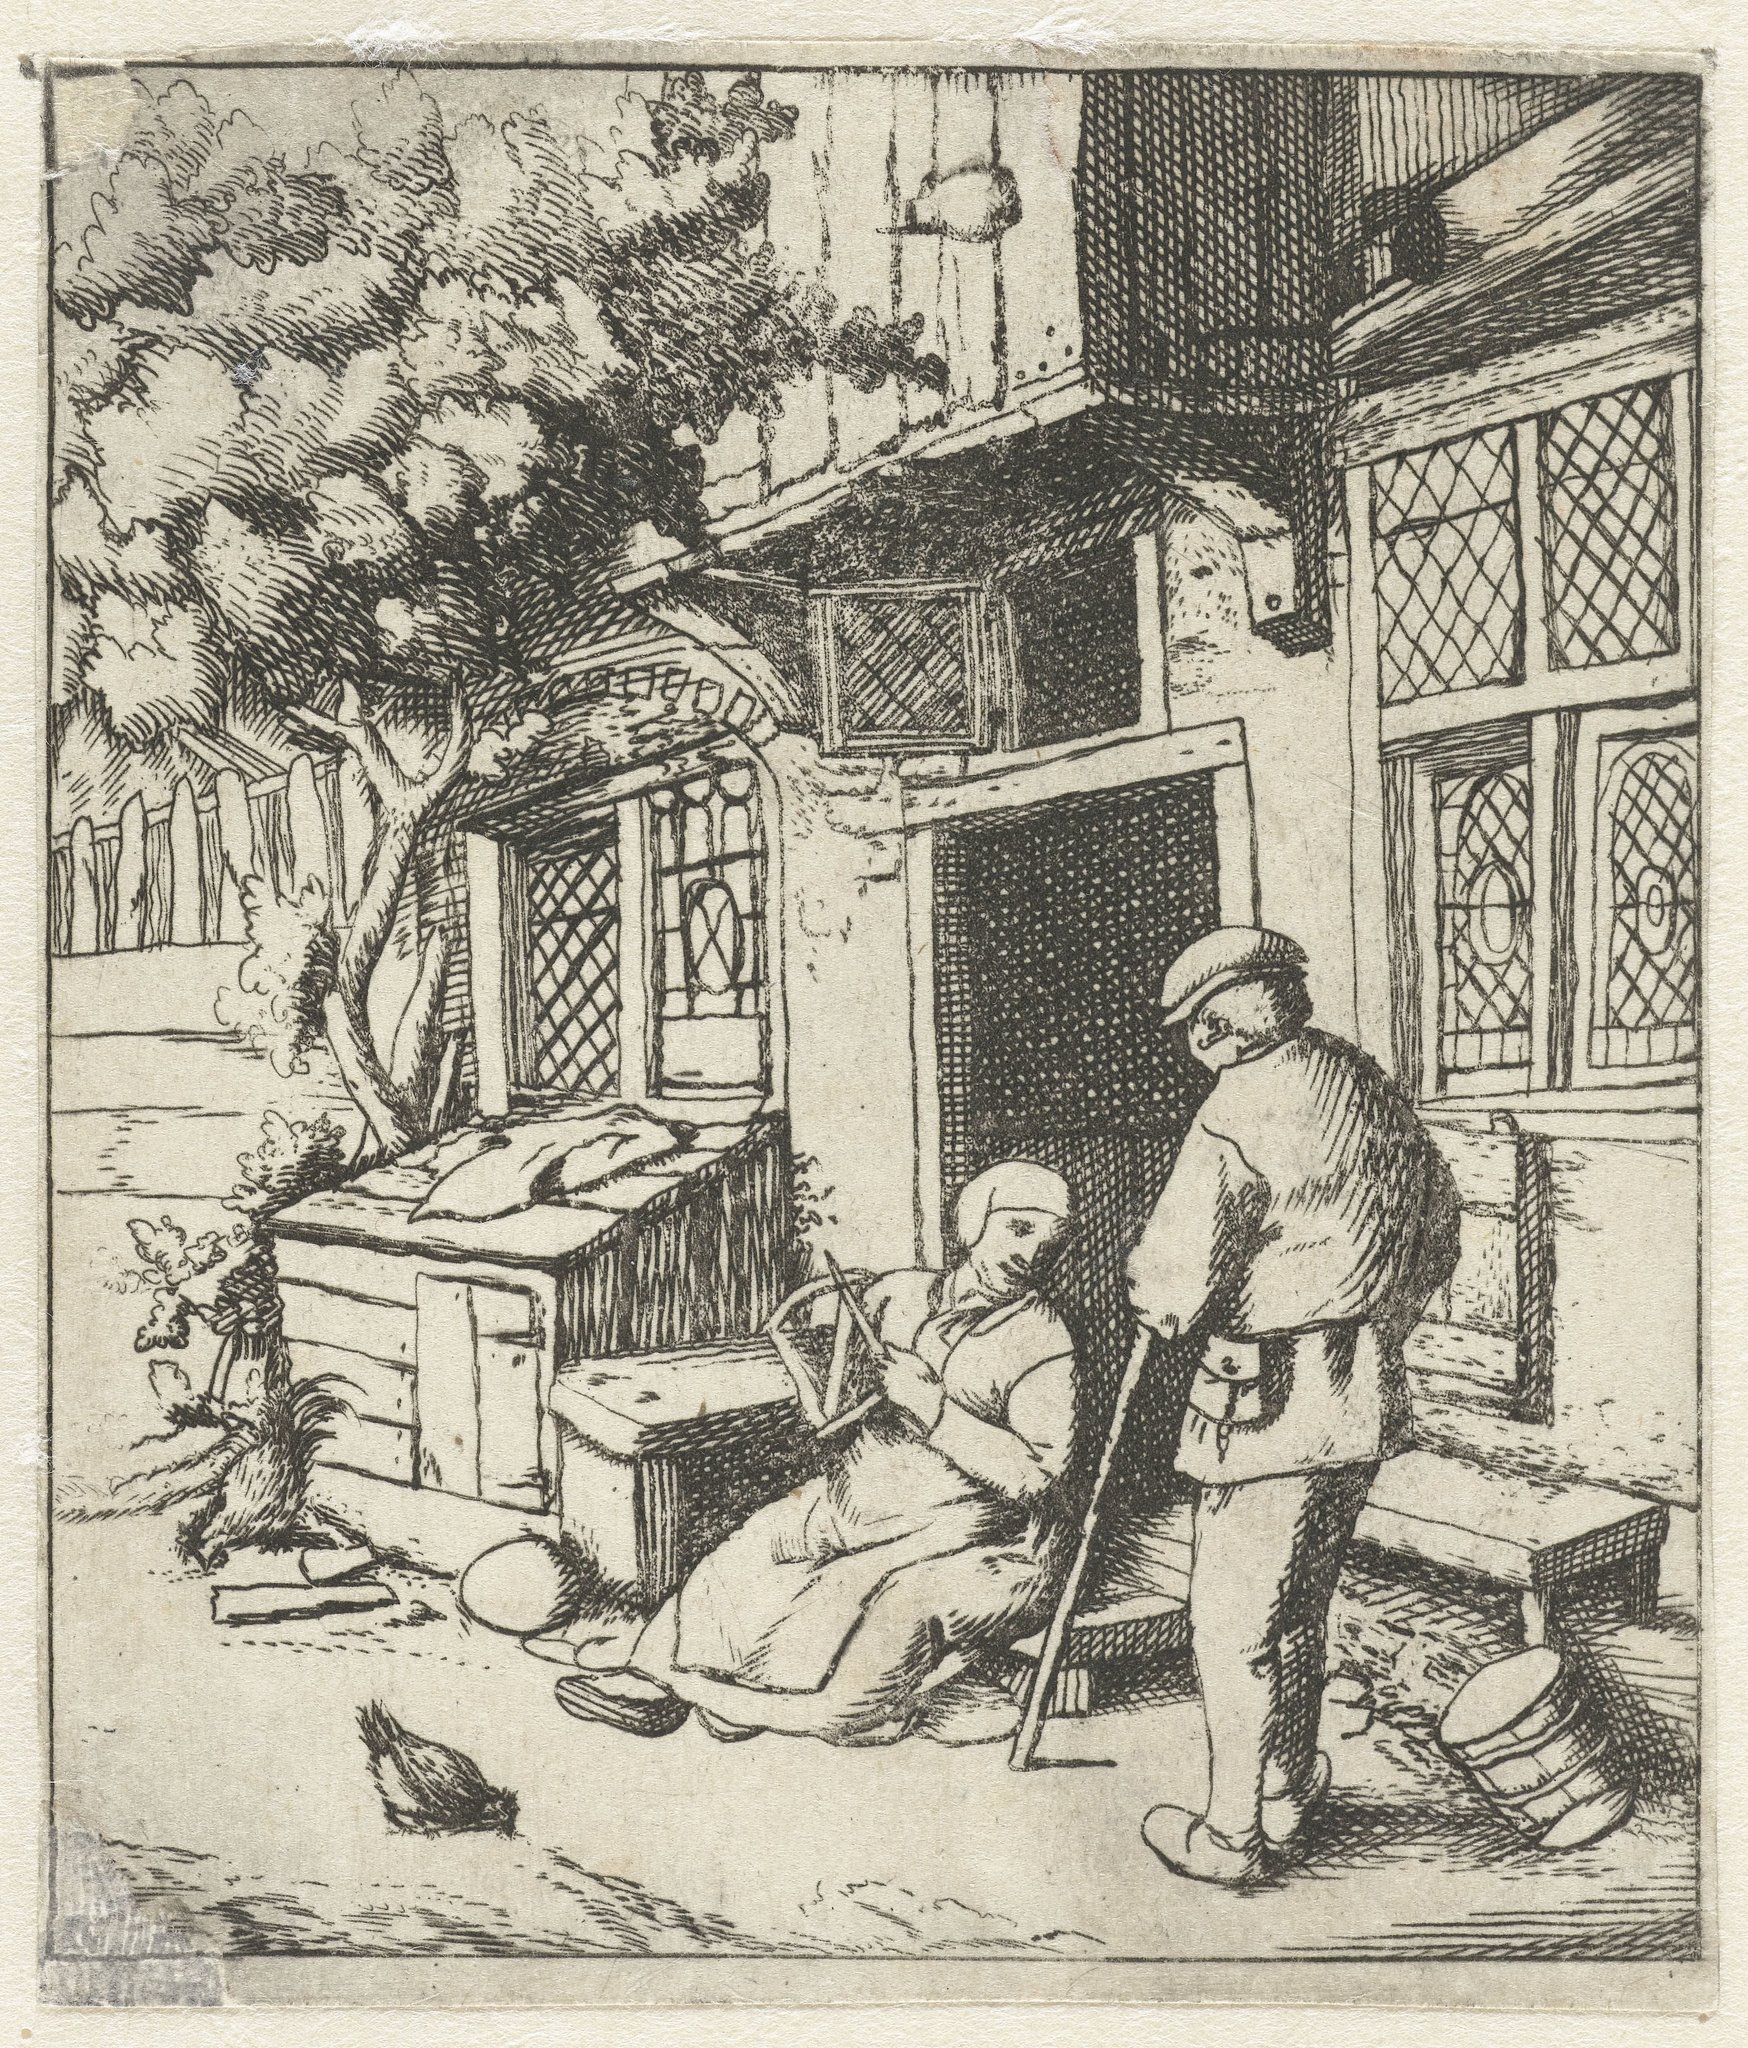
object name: kopie naar prent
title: De spinster voor haar deur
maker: Anonymous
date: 1666-1745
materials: paper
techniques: etching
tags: winding of yarn on reels or spools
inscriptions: collector's mark: Lugt 240